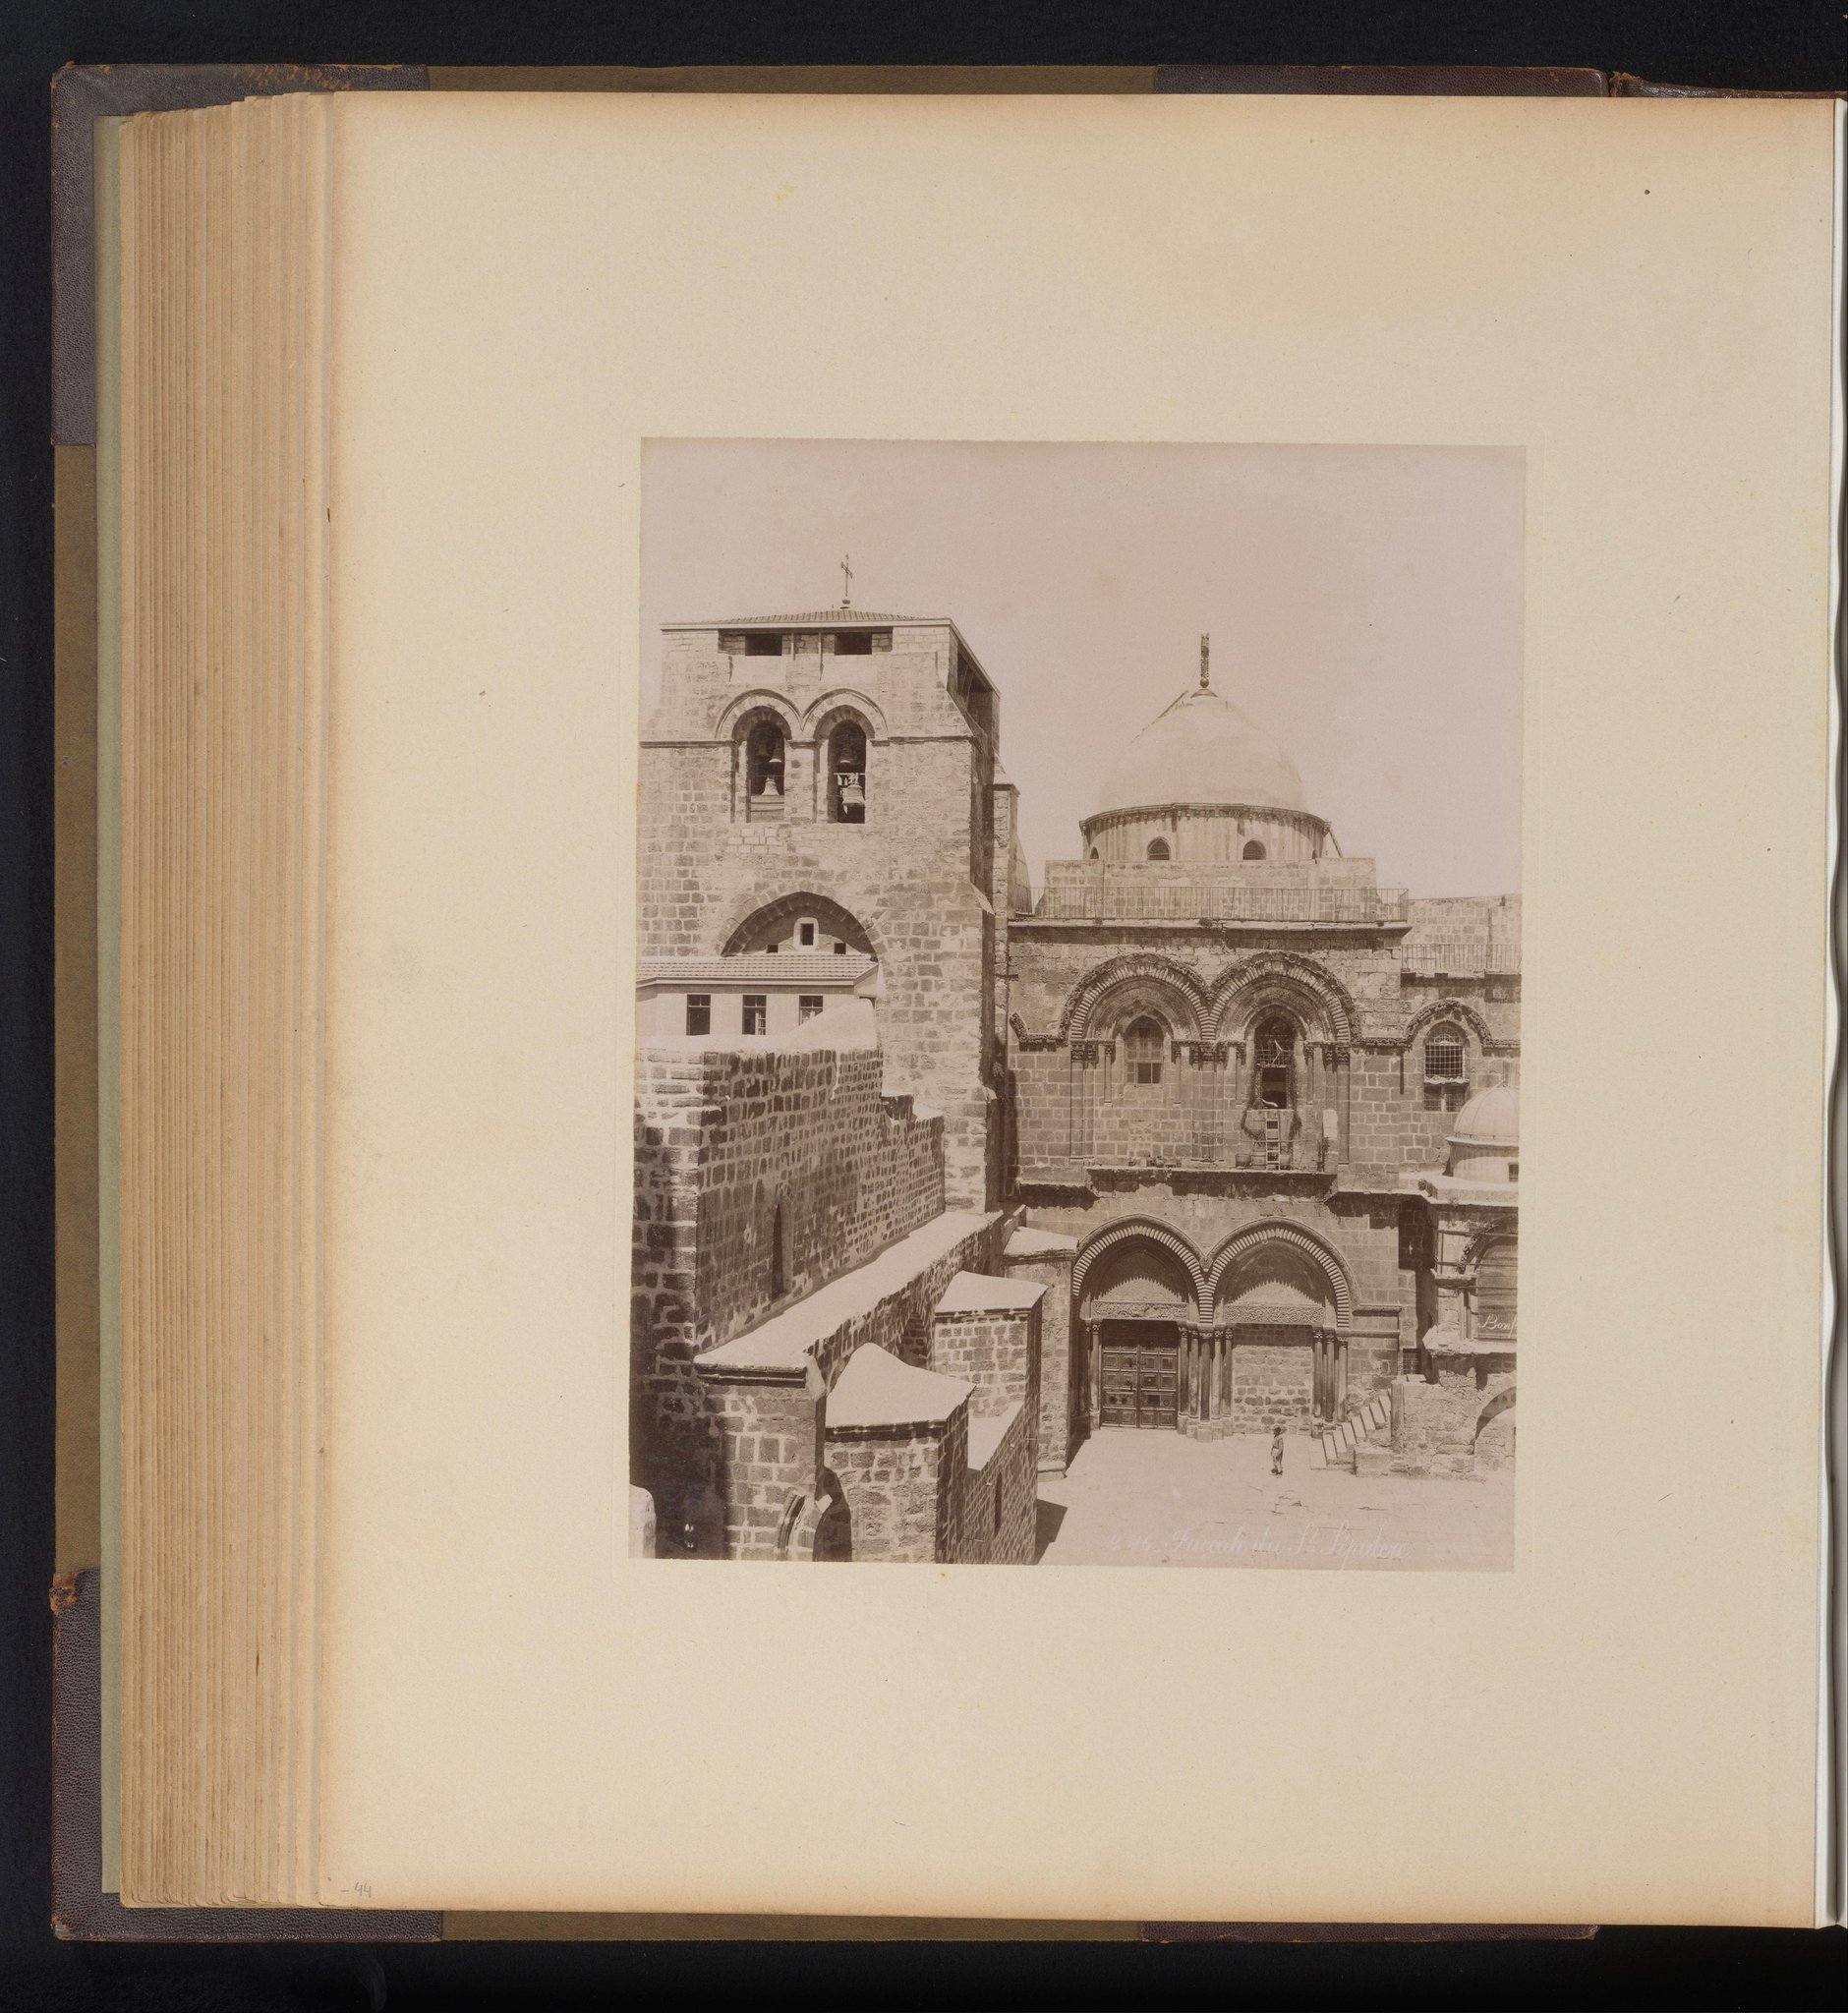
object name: photograph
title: Façade du Ste Sépulchre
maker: félix bonfils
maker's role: fotograaf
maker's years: 1831-1885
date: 1867-1885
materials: paper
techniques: albumen print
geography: jerusalem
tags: church (exterior)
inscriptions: number: ‘2116 [?]’